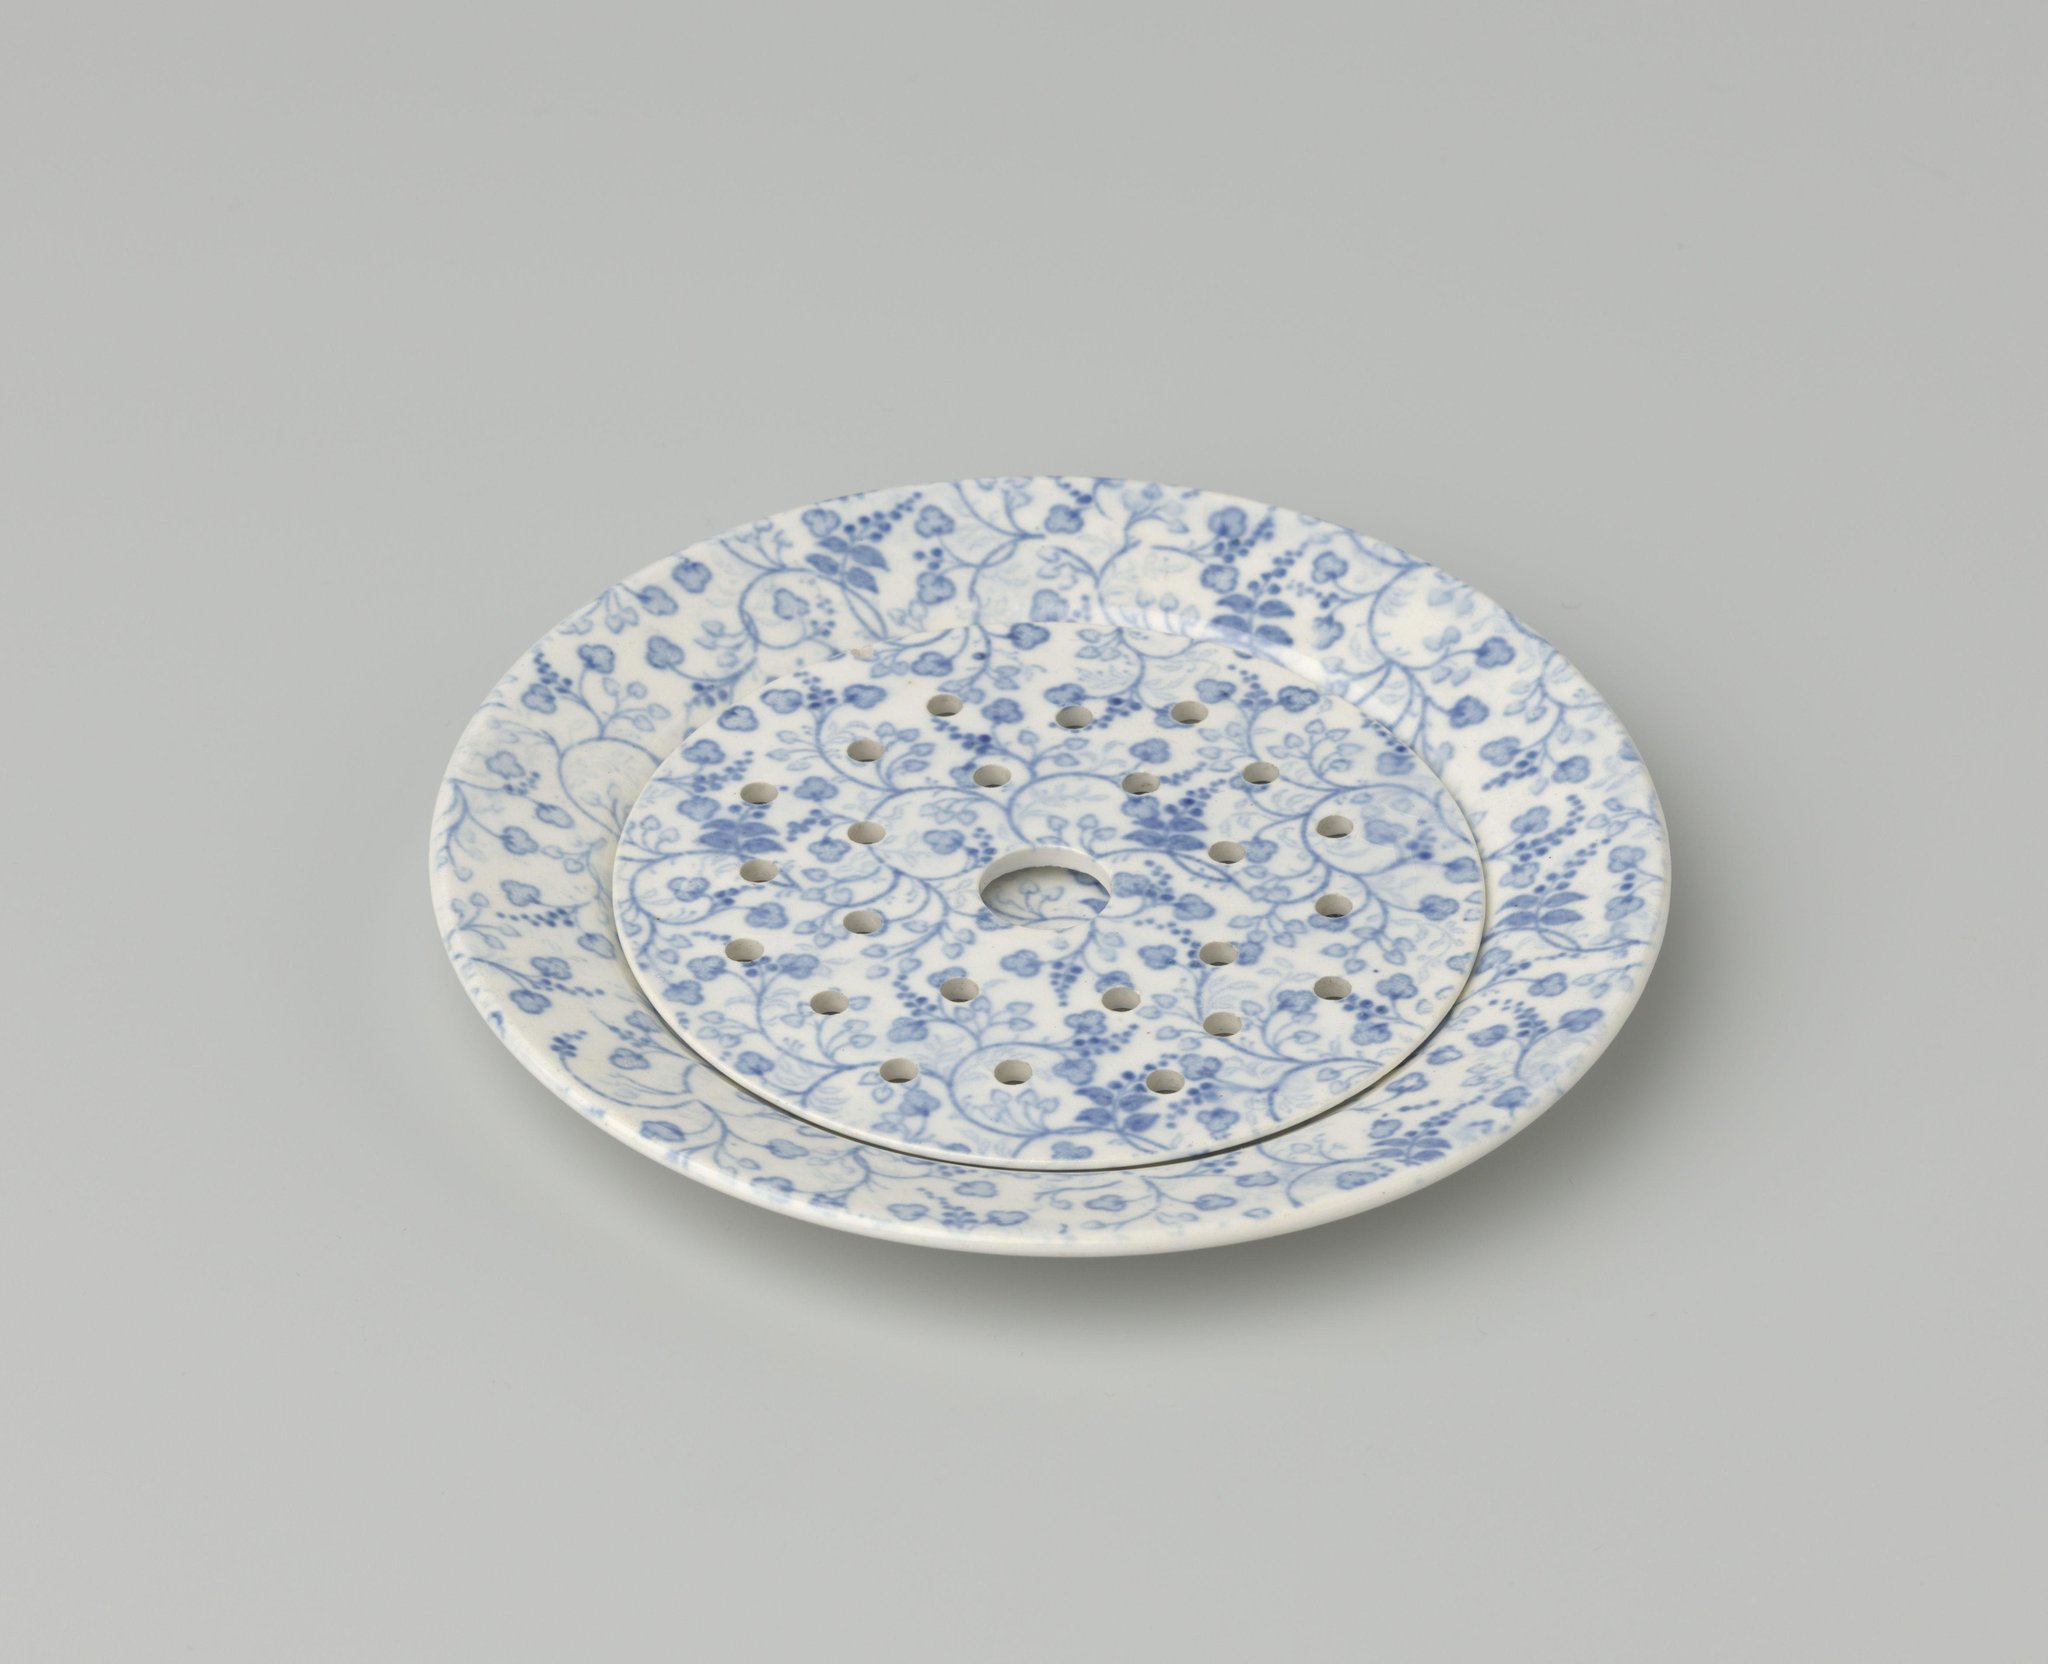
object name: trivet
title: Treeft, behorend bij schotel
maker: petrus regout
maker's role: plateelbakker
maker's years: 1801-1879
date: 1867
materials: creamware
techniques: transfer decoration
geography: maastricht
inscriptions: check stamp: ‘PR // 2 45’, mark: ‘PARSEME No 3’, check stamp: ‘PR 24’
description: Treeft van aardewerk, rond, met blauw doorlopend bloemendecor, behorend tot een kinderservies. De treeft heeft vijfentwintig gaten.